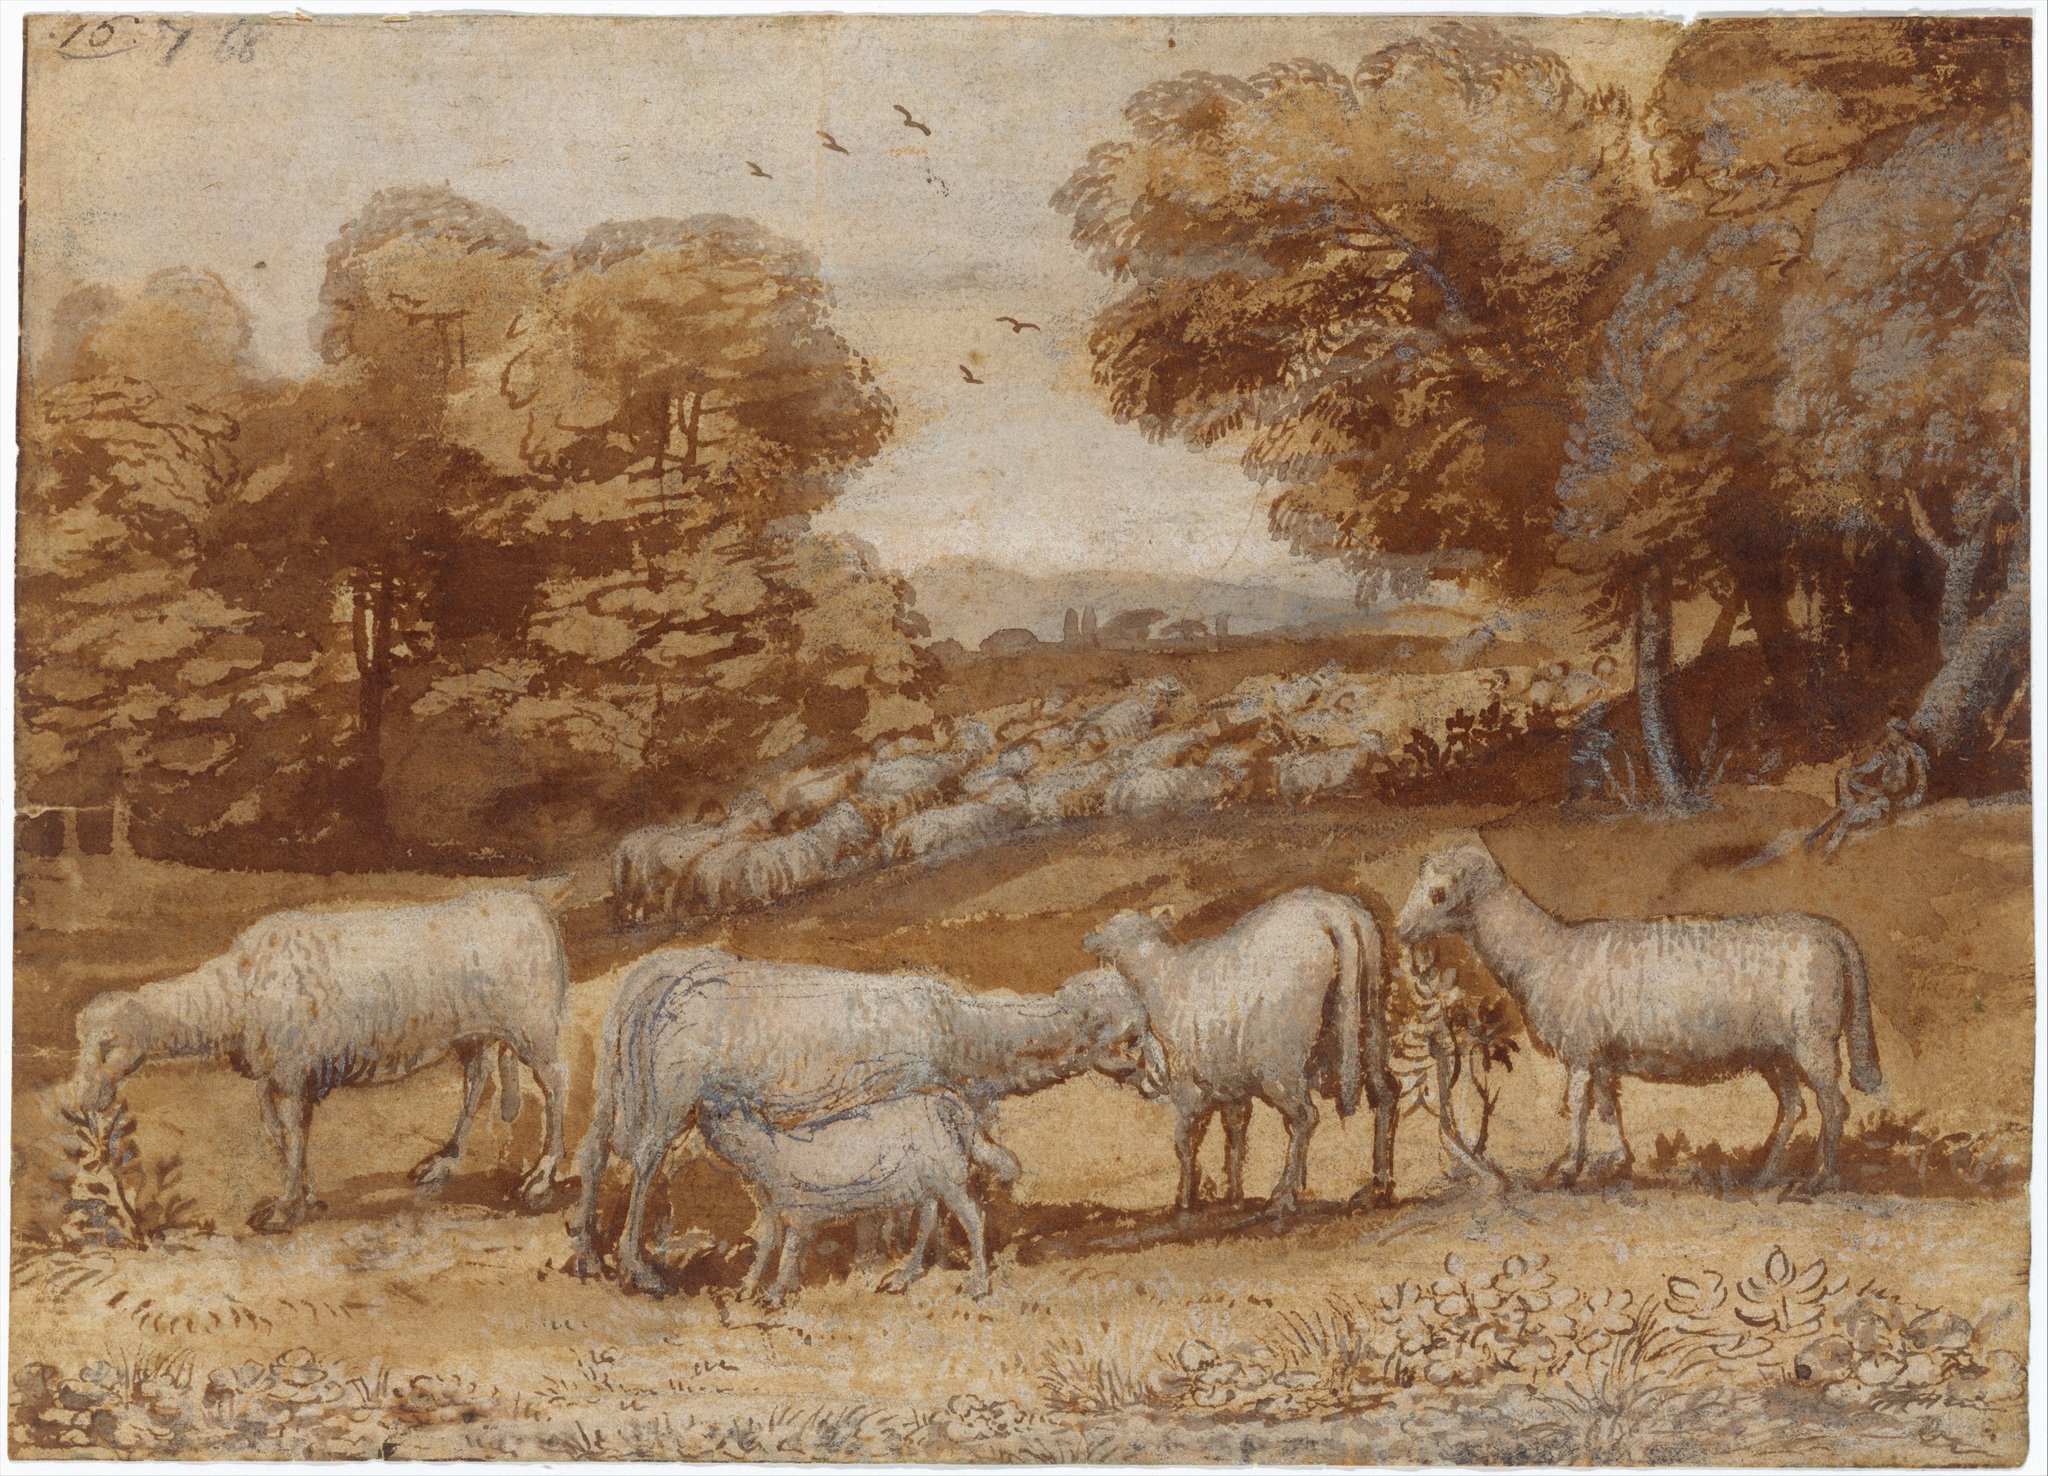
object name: drawing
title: Landscape with Sheep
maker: claude lorrain (claude gellée)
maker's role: artist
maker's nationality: french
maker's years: 1604-1682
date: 1648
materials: chalk, gouache, ink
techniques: heightening, wash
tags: sheep,landscapes